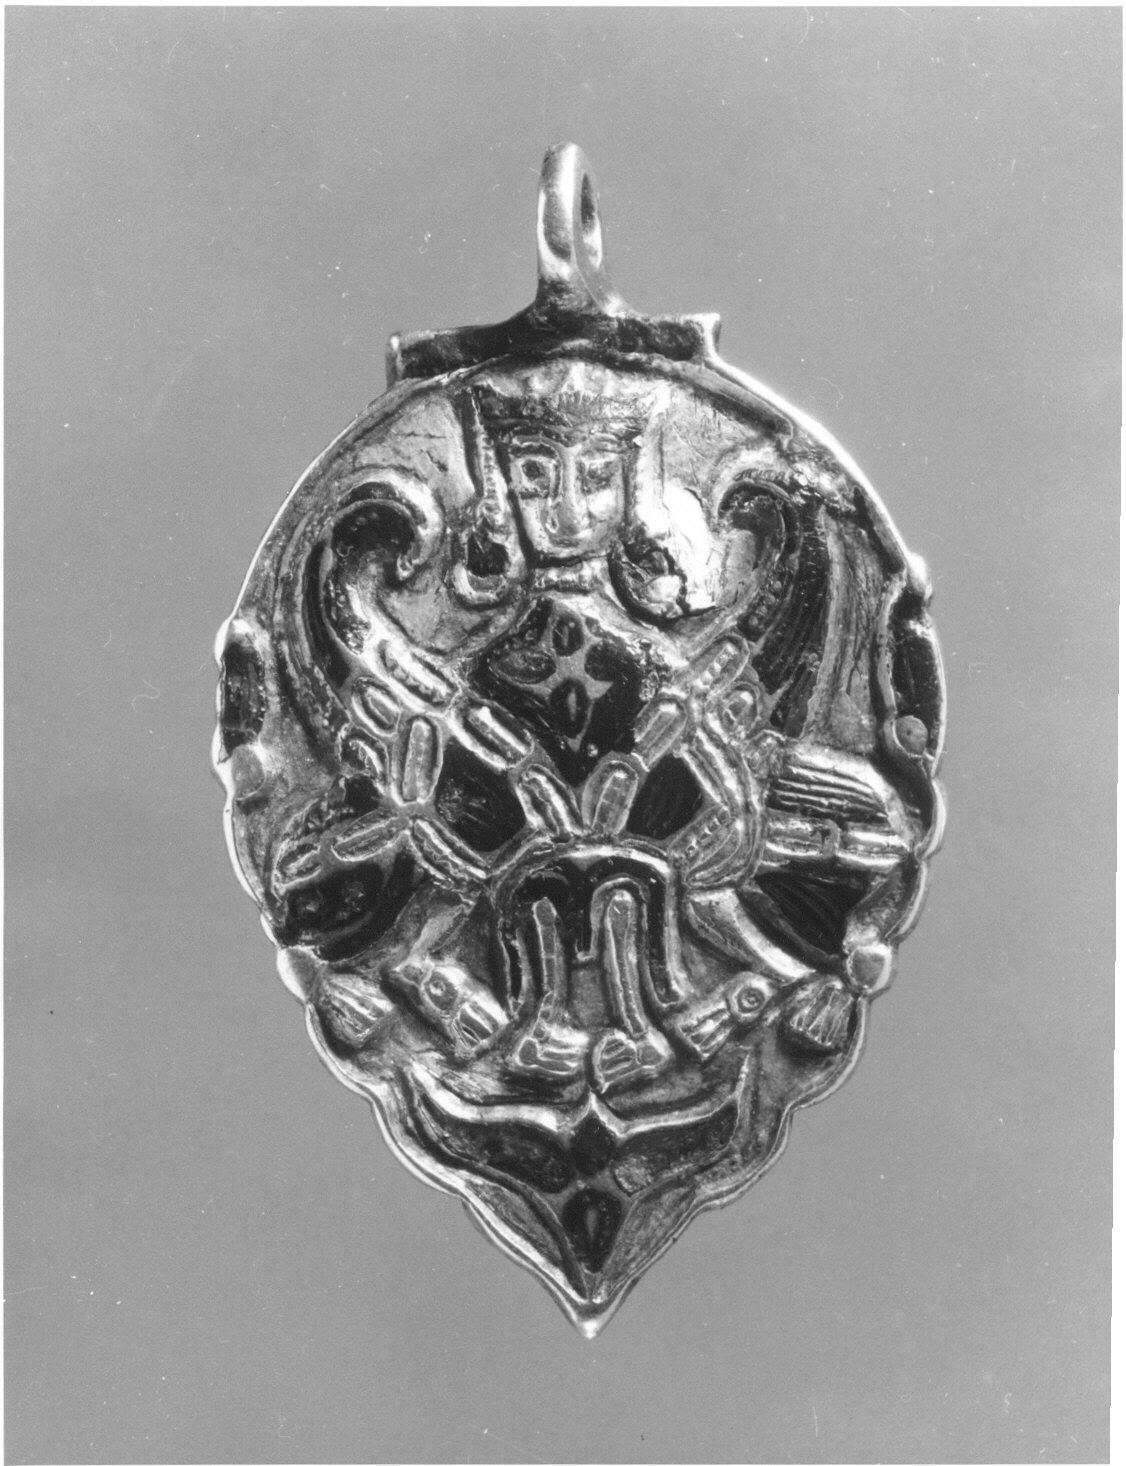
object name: pendant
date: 1101-1300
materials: gilt, niello, silver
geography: iran